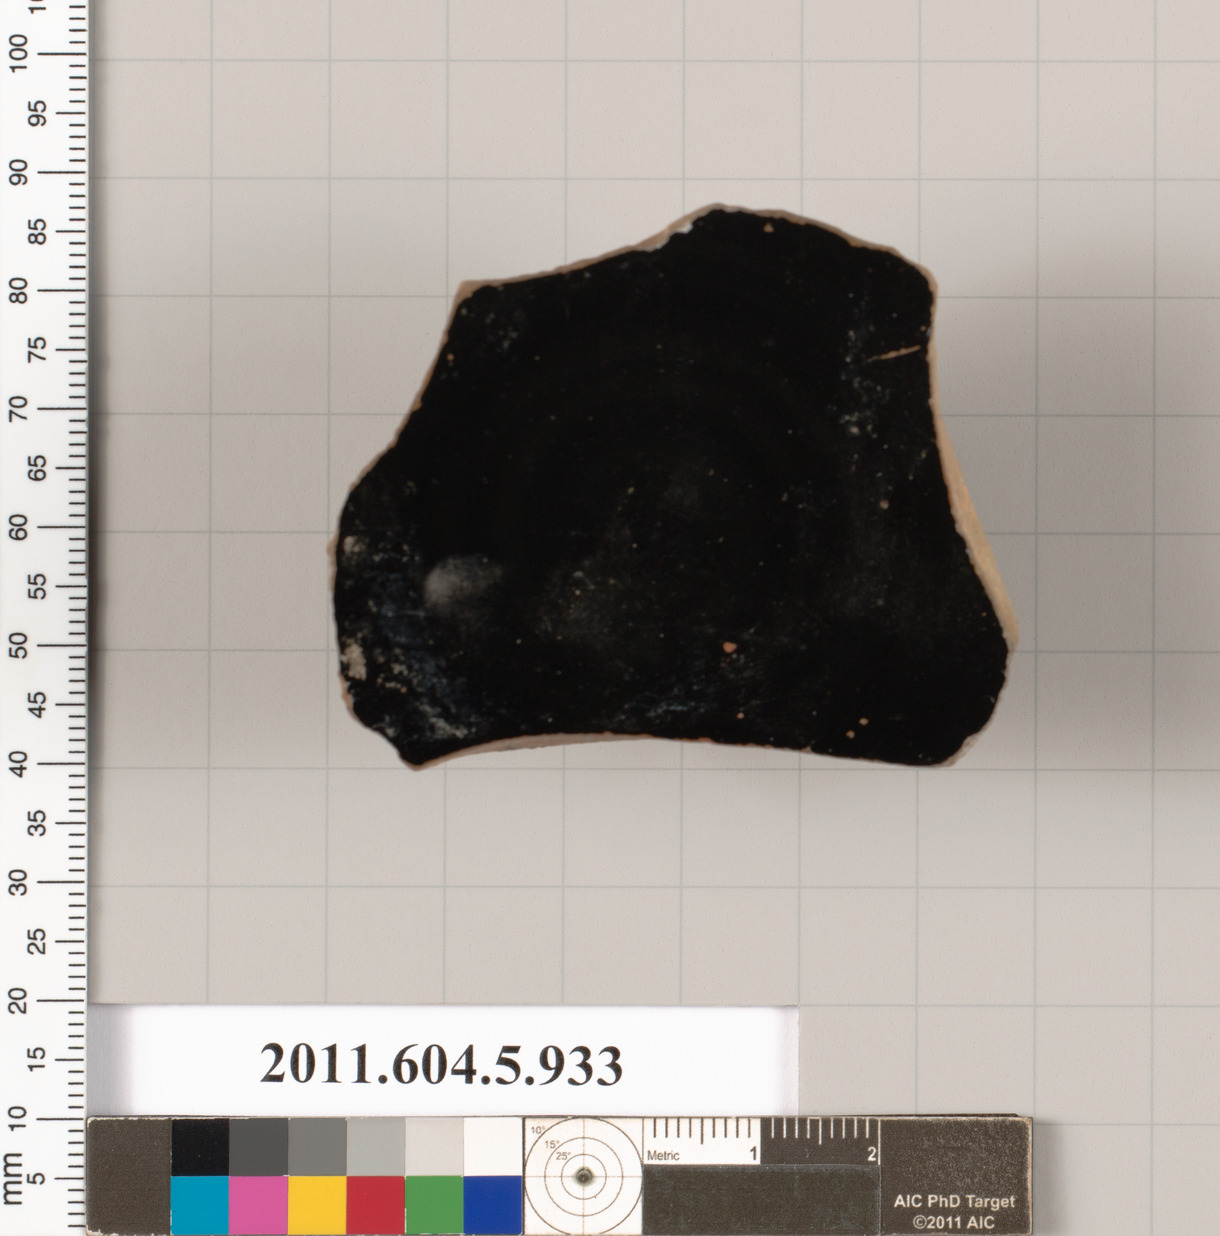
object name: kylix fragment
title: Terracotta fragment of a kylix (drinking cup)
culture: greek, attic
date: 600-401 BCE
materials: terracotta